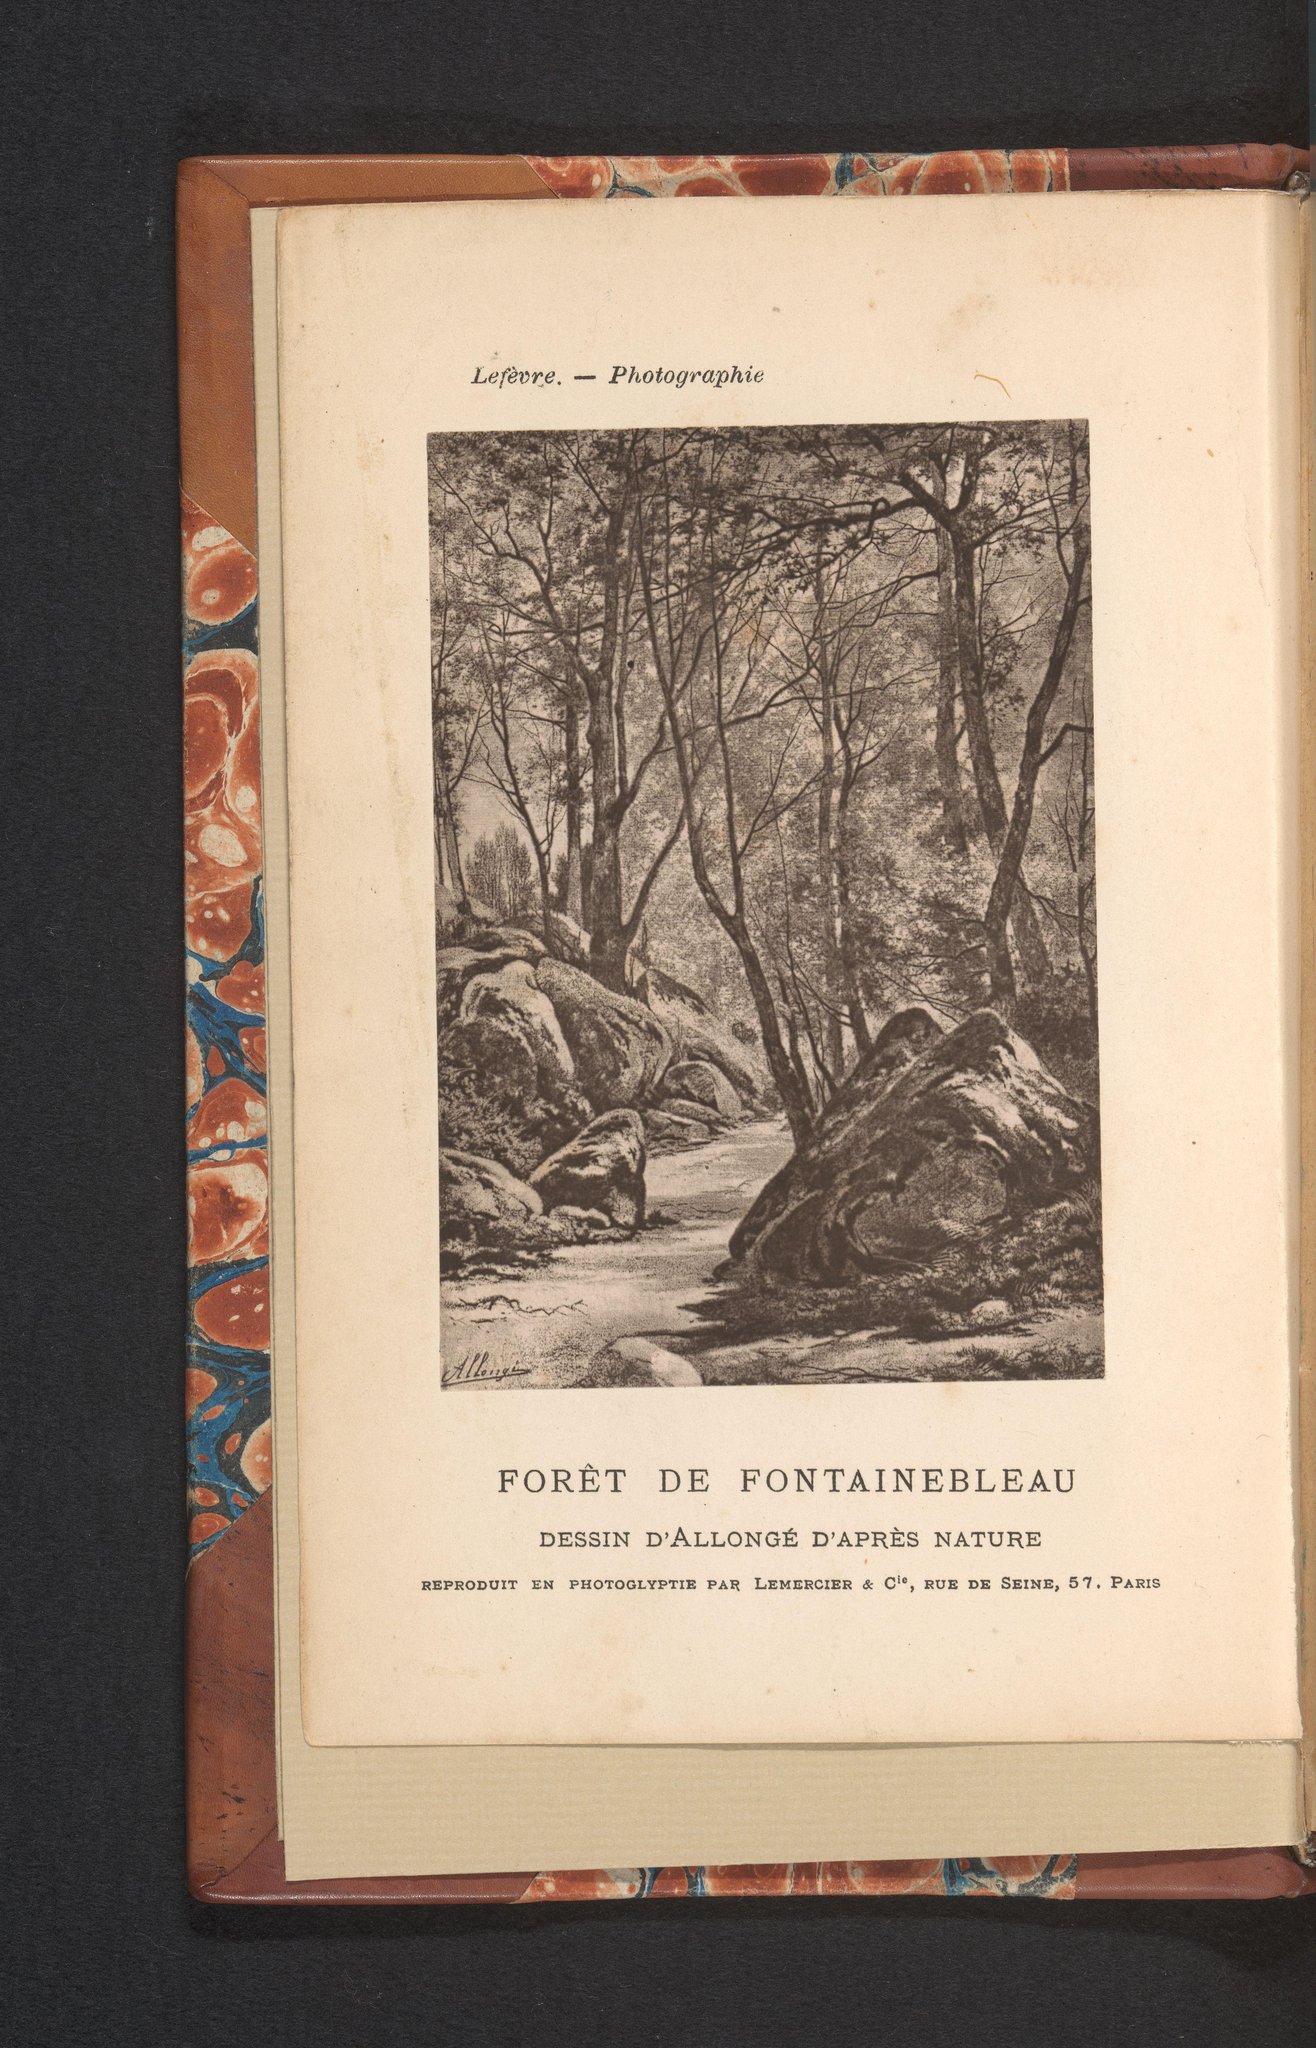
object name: page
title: Reproductie van Forêt de Fontainebleau door Auguste Allongé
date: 1883-1888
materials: paper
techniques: woodburytype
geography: paris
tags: forest, wood, painting, drawing and the graphic arts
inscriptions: inscription: ‘Lefevre - Photographie’